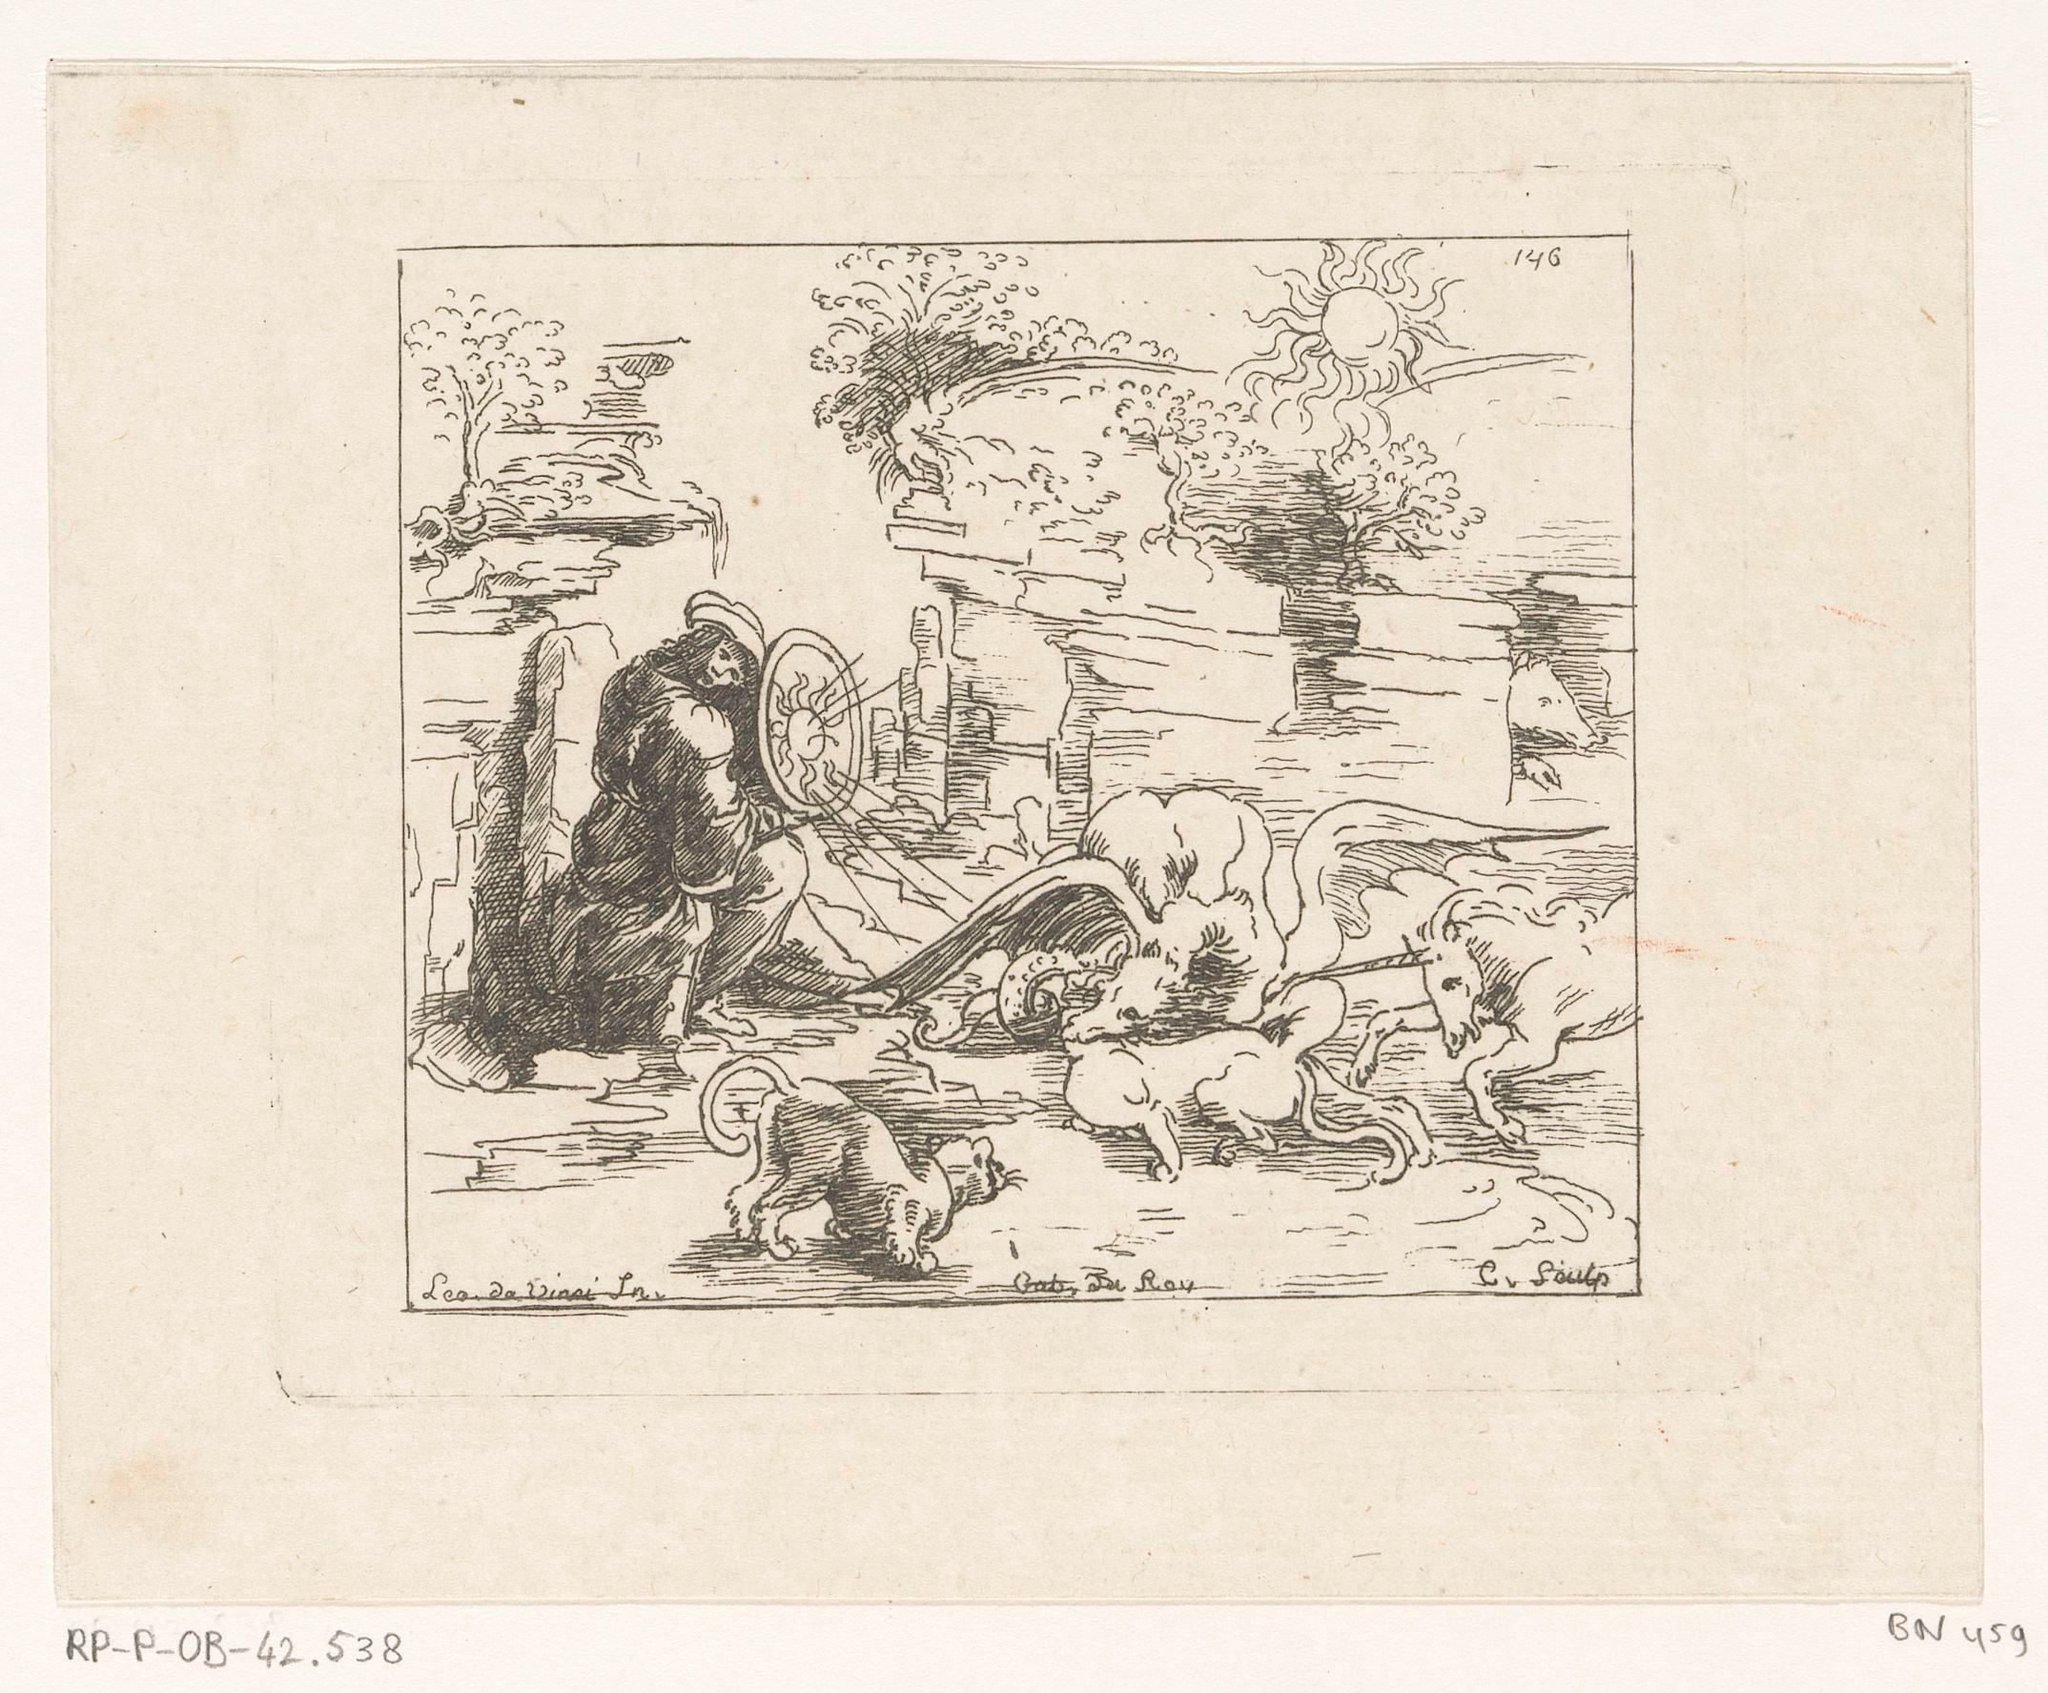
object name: print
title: Man die een schild ophoudt voor een vechtende draak en eenhoorn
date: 1702-1765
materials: paper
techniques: etching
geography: france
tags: unicorn, dragon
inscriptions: collector's mark: Lugt 240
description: Maakt deel uit van een serie getiteld: "Cabinet du Roy" van 222 etsen naar tekeningen uit de Franse koninklijke collectie. De tekening door Da Vinci bevindt zich in het Musée du Louvre te Parijs, inv.nr. BB 1064.